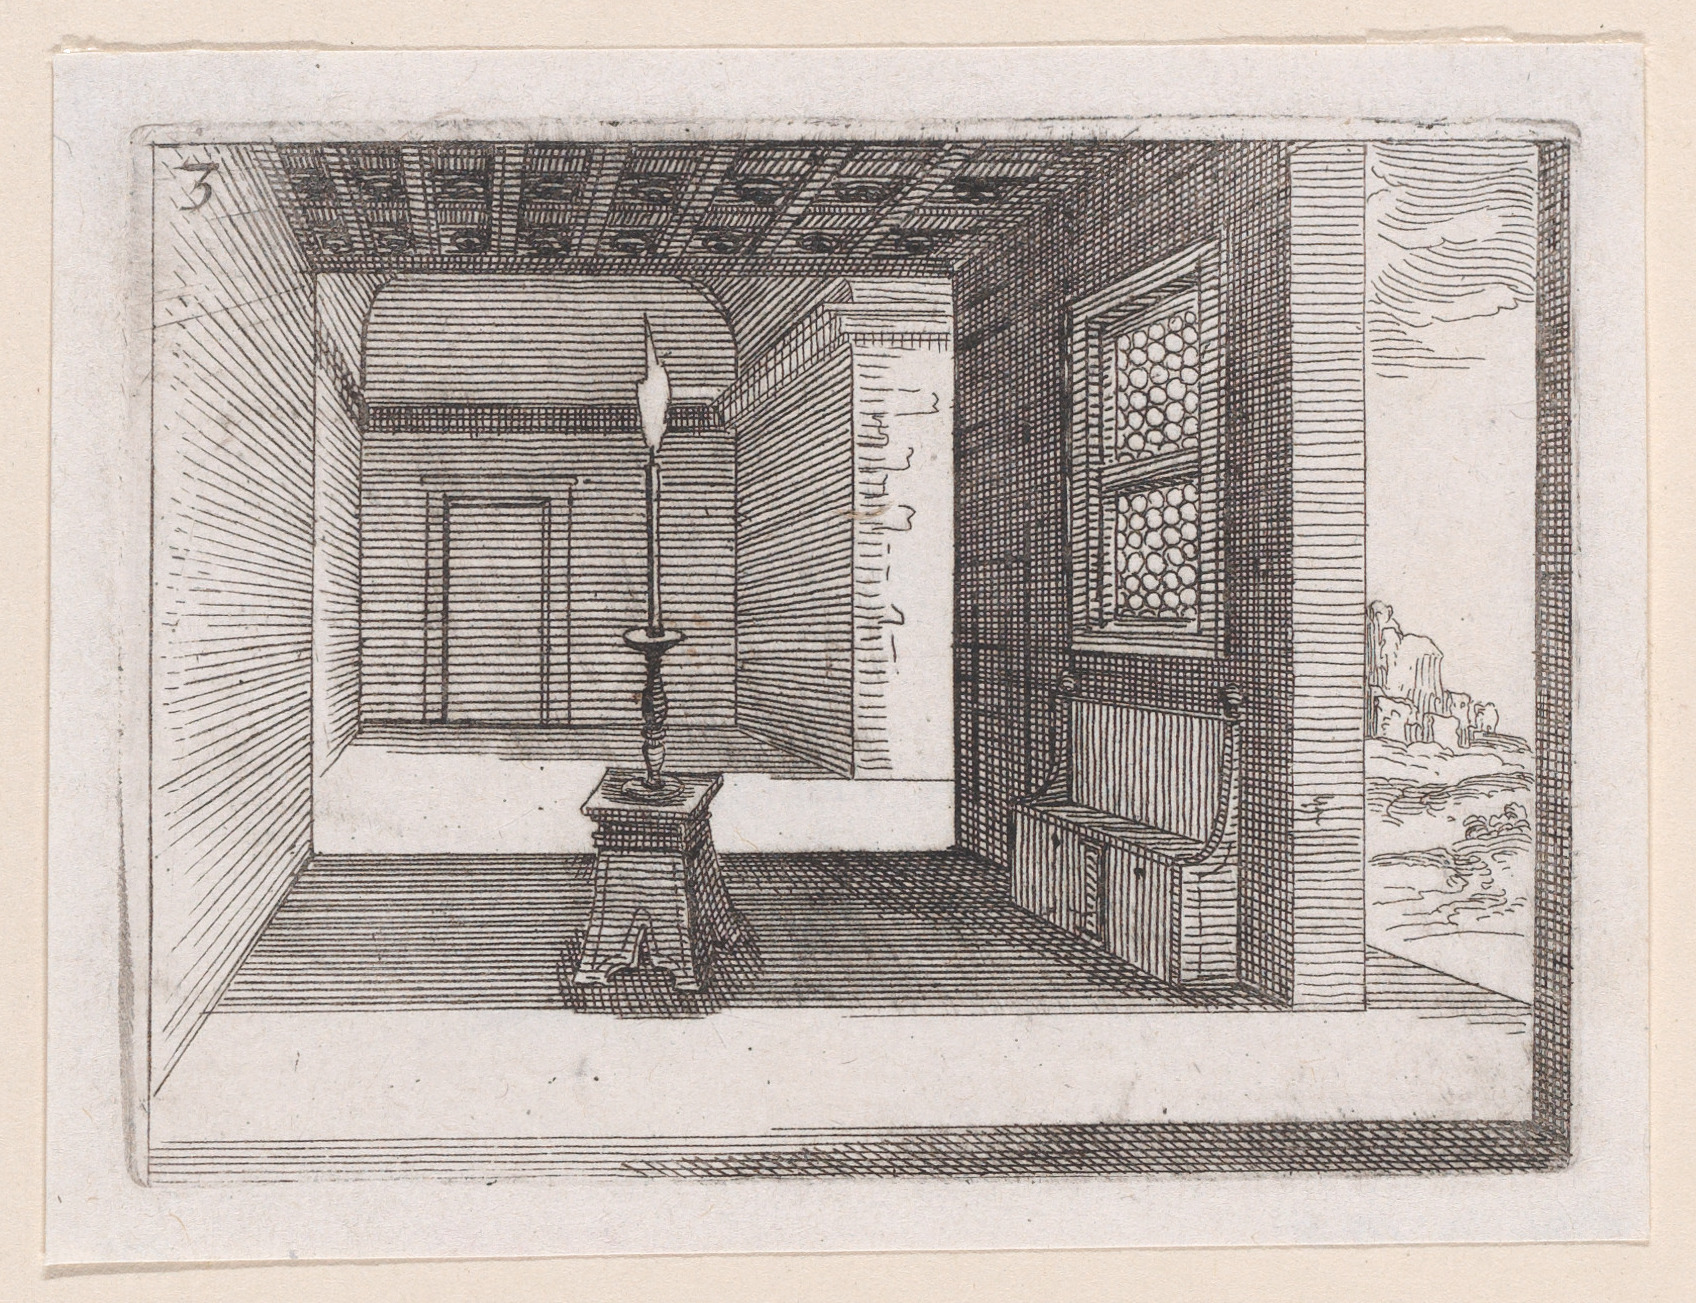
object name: print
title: Le Chandelier (The Candlabra), plate 3 from "Lux Claustri ou La Lumière du Cloitre" (The Light of the Cloisters)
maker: jacques callot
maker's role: artist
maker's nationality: french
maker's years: 1592-1635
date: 1621-1635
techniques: etching